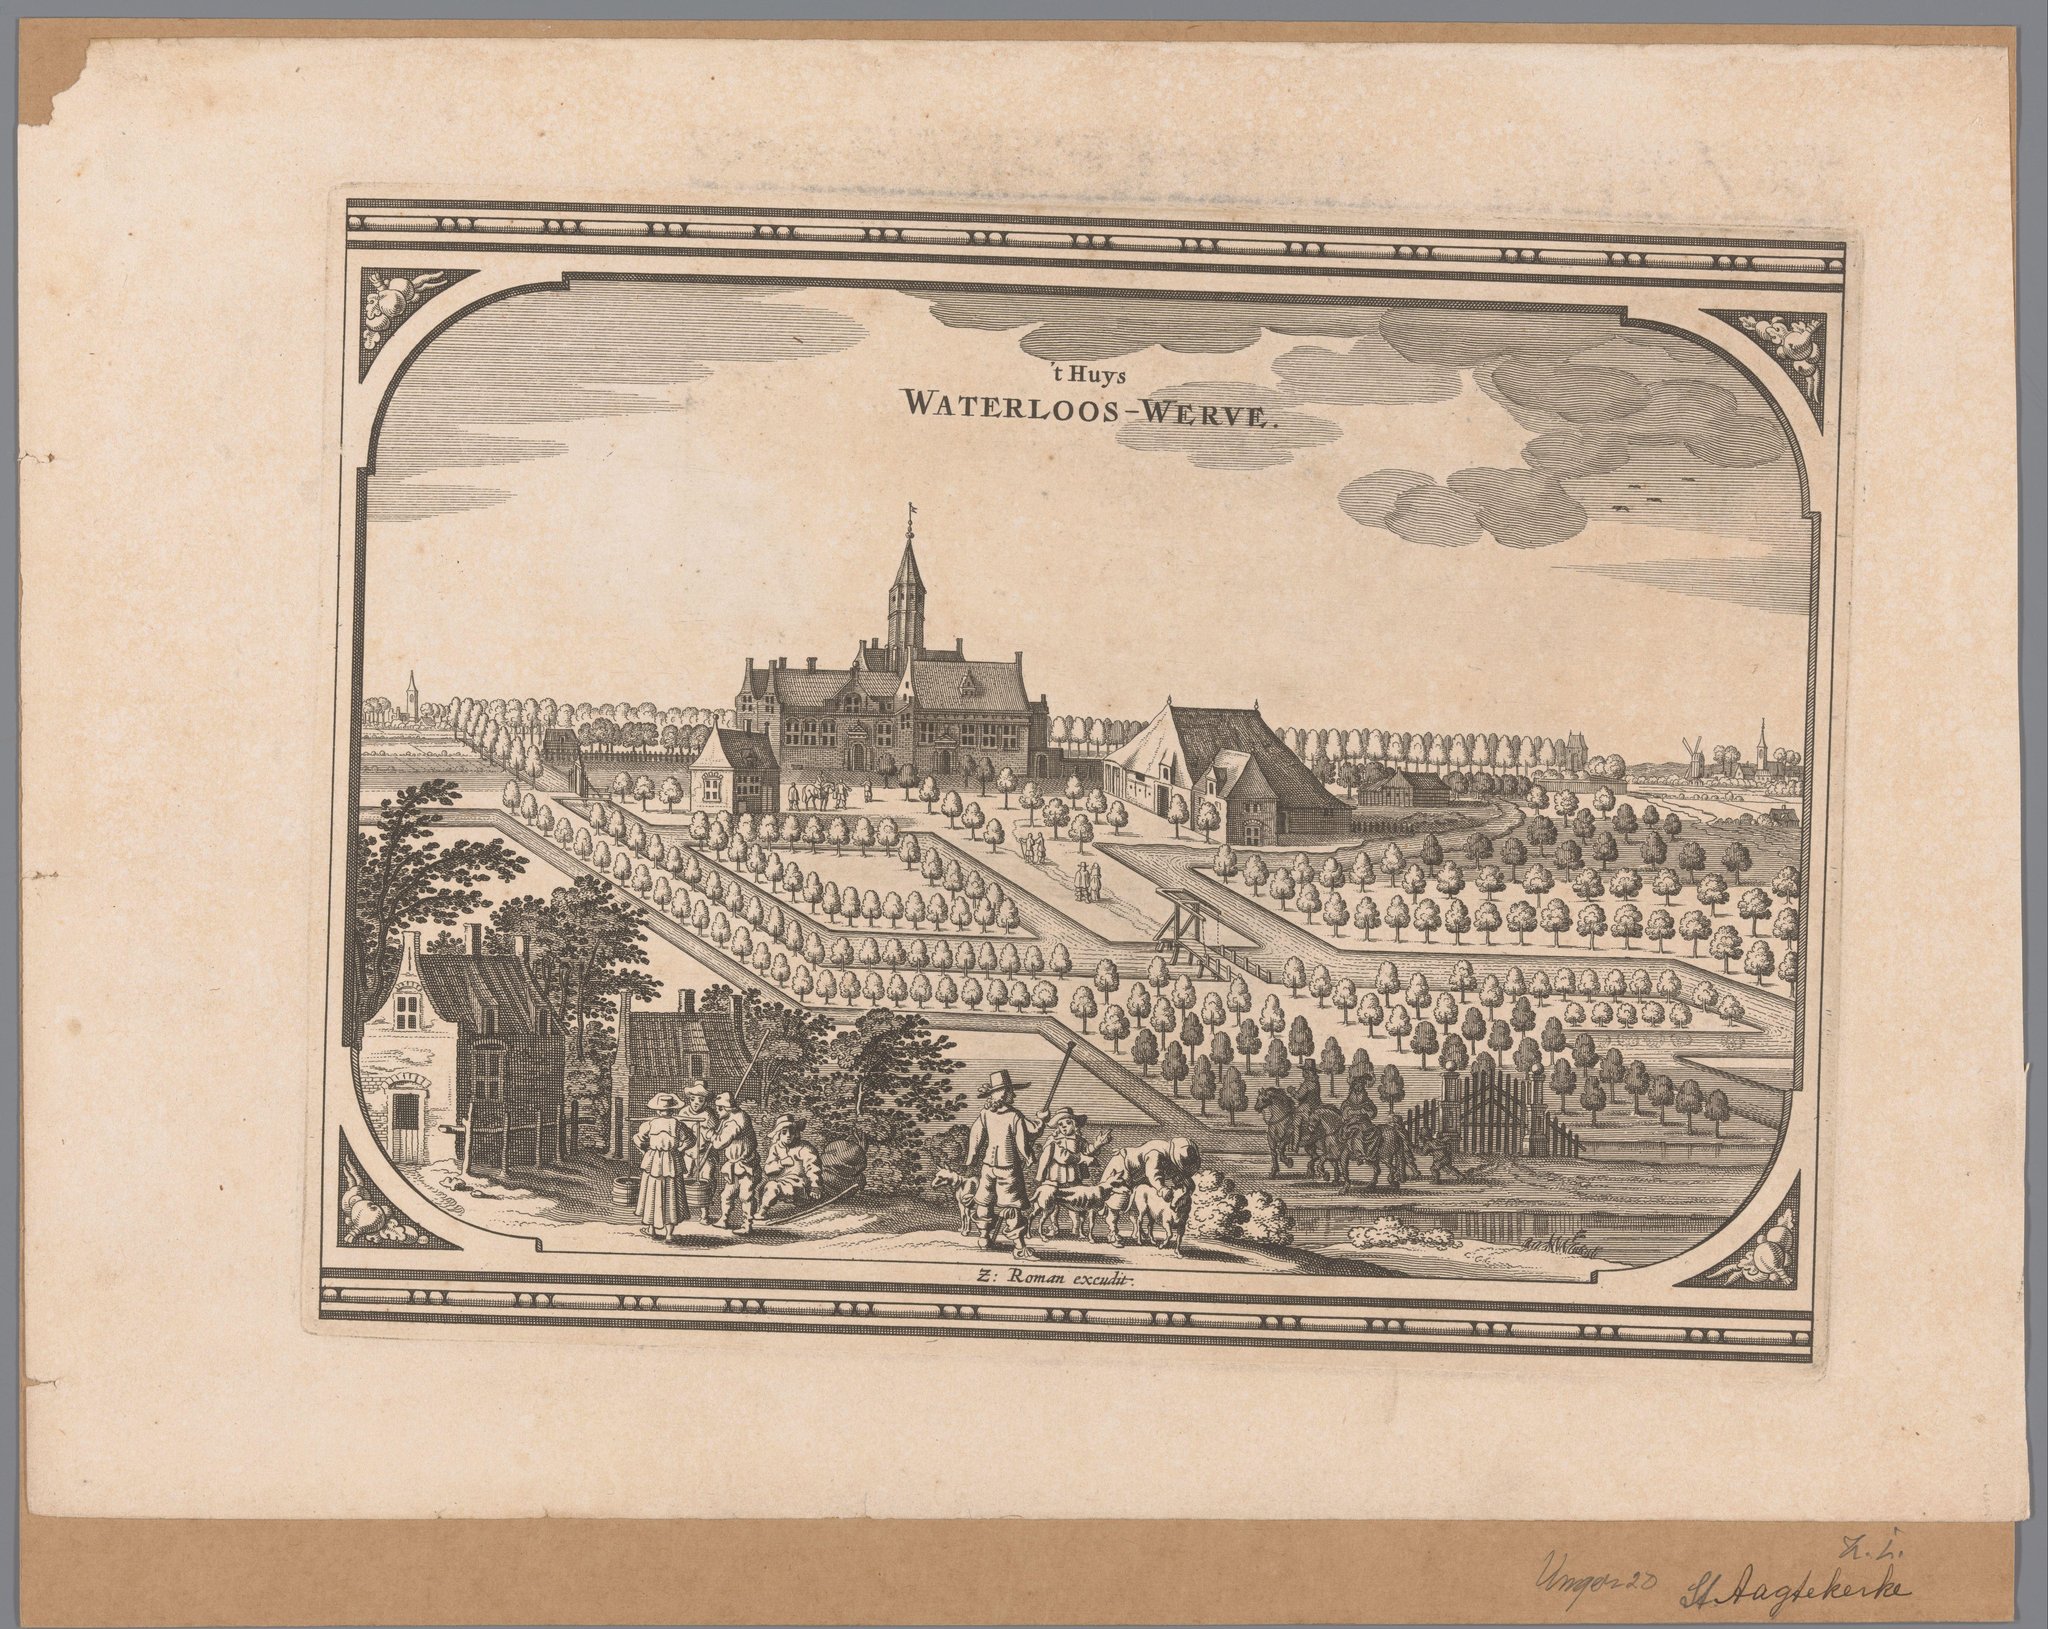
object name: print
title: Gezicht op huis Waterslooswerve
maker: pieter hendricksz. schut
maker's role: print maker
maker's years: 1618-1660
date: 1657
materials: paper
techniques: etching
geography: amsterdam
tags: city-view, and landscape with man-made constructions, villa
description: Huidige staat van prent gebruikt in: Theatrum praecipuarum urbium ducatus Brabantiae nec non comitatuum Flandriae et Zelandiae. Amsterdam: Nicolaes Visscher (I), 1657. Verwarring rondom de datering kan ontstaan door het feit dat de prenten die voorkomen in de bovengenoemde publicatie ook voorkomen in een eerder uitgegeven publicatie, waar ze later in zijn ingebonden (Boxhorn, Marcus Zuerius van. Chroniick van Zeelandt (…). 2 dln. Middelburg: Zacharias Roman, 1644.